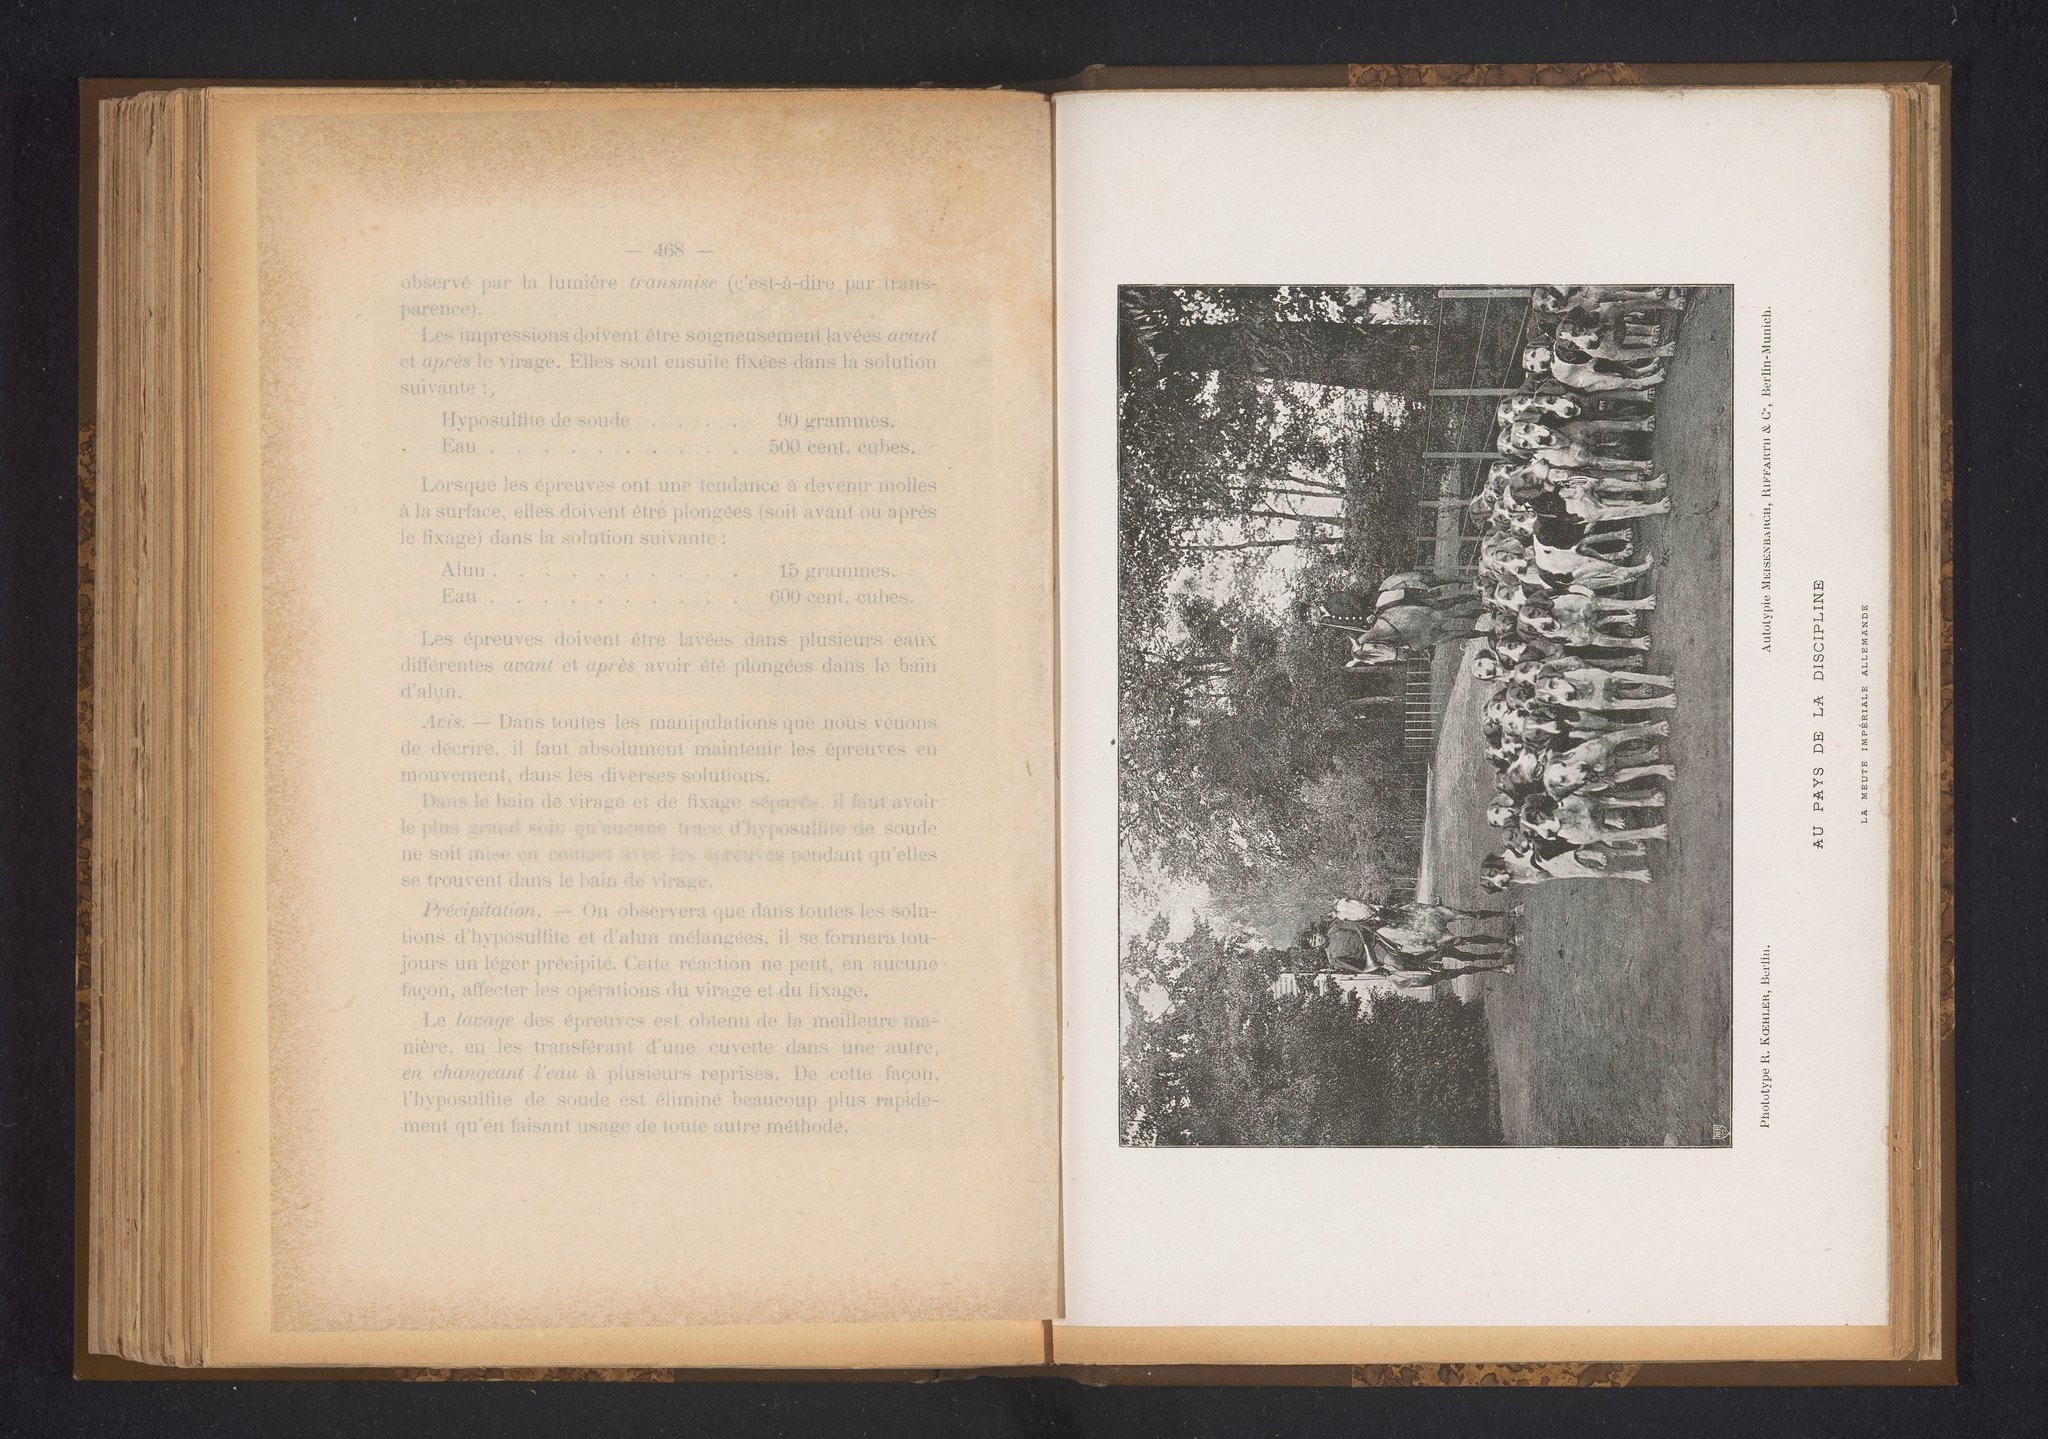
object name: photomechanical print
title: Au pays de la discipline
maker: r. koehler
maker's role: fotograaf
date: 1887-1892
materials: paper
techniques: photograph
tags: riding a horse, ass, or mule; rider, horseman, adult man, horse, dog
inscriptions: inscription: ‘Le muete impériale allemande’